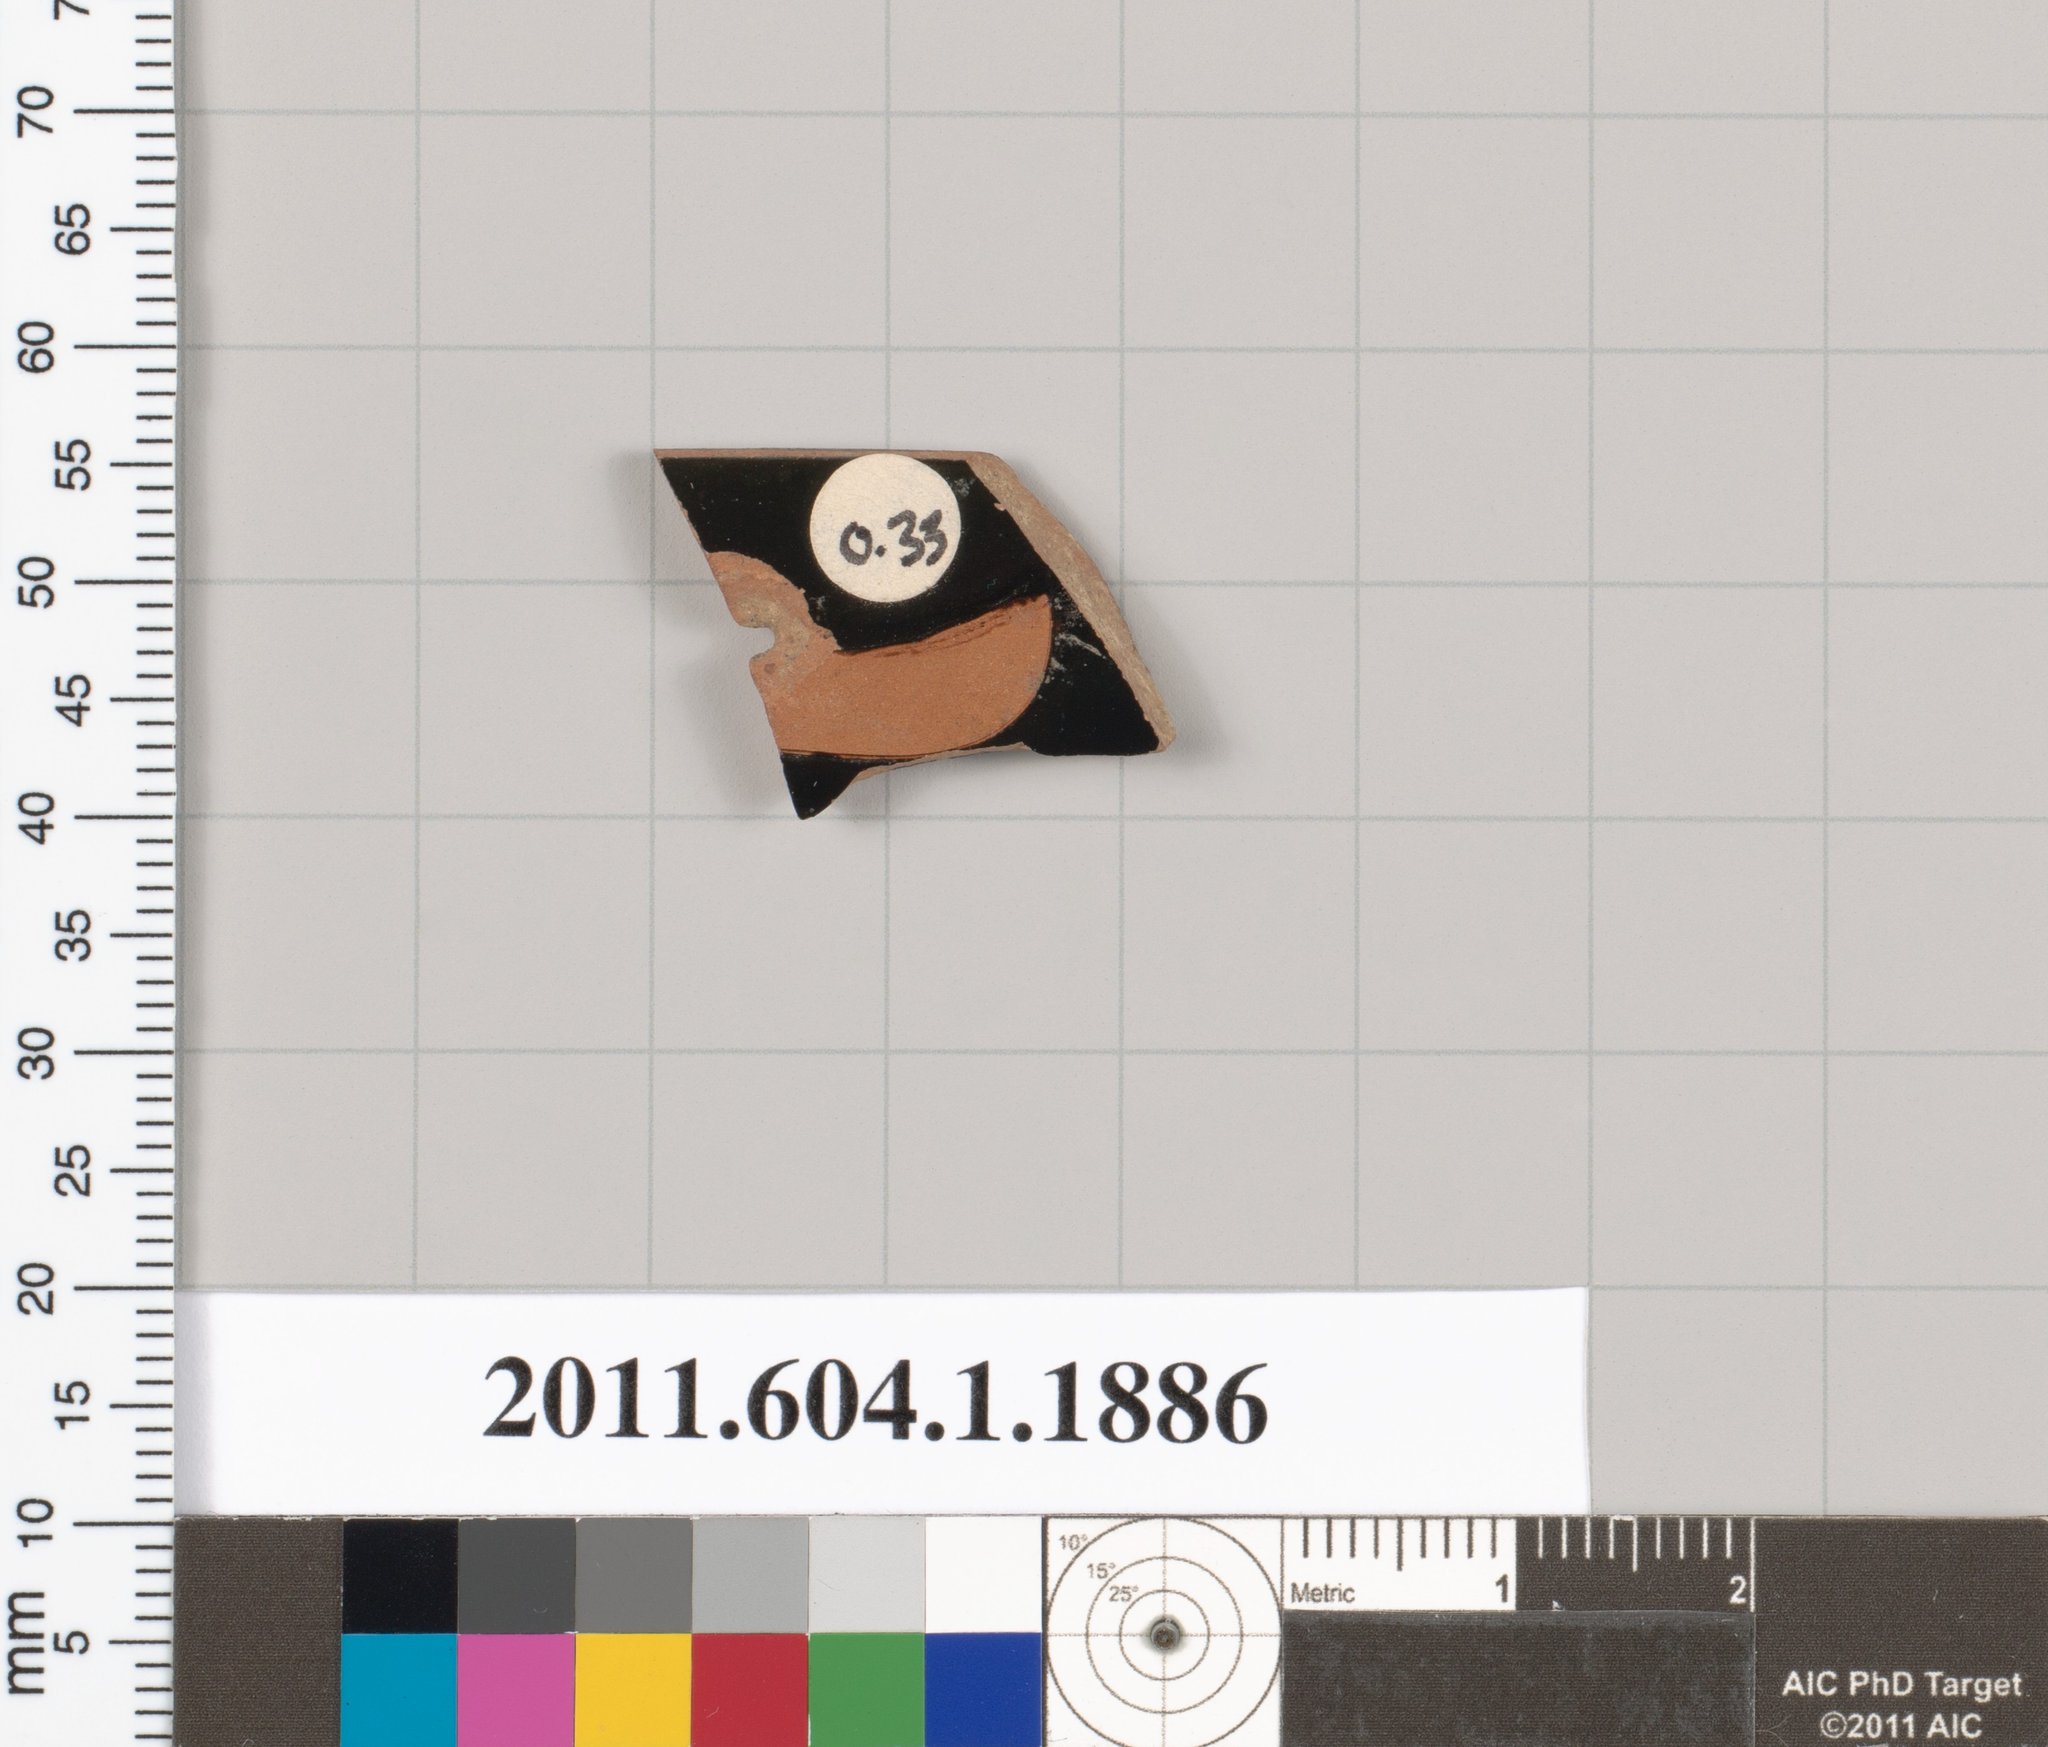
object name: kylix fragment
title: Terracotta rim fragment of a kylix (drinking cup)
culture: greek, attic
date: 475-451 BCE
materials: terracotta